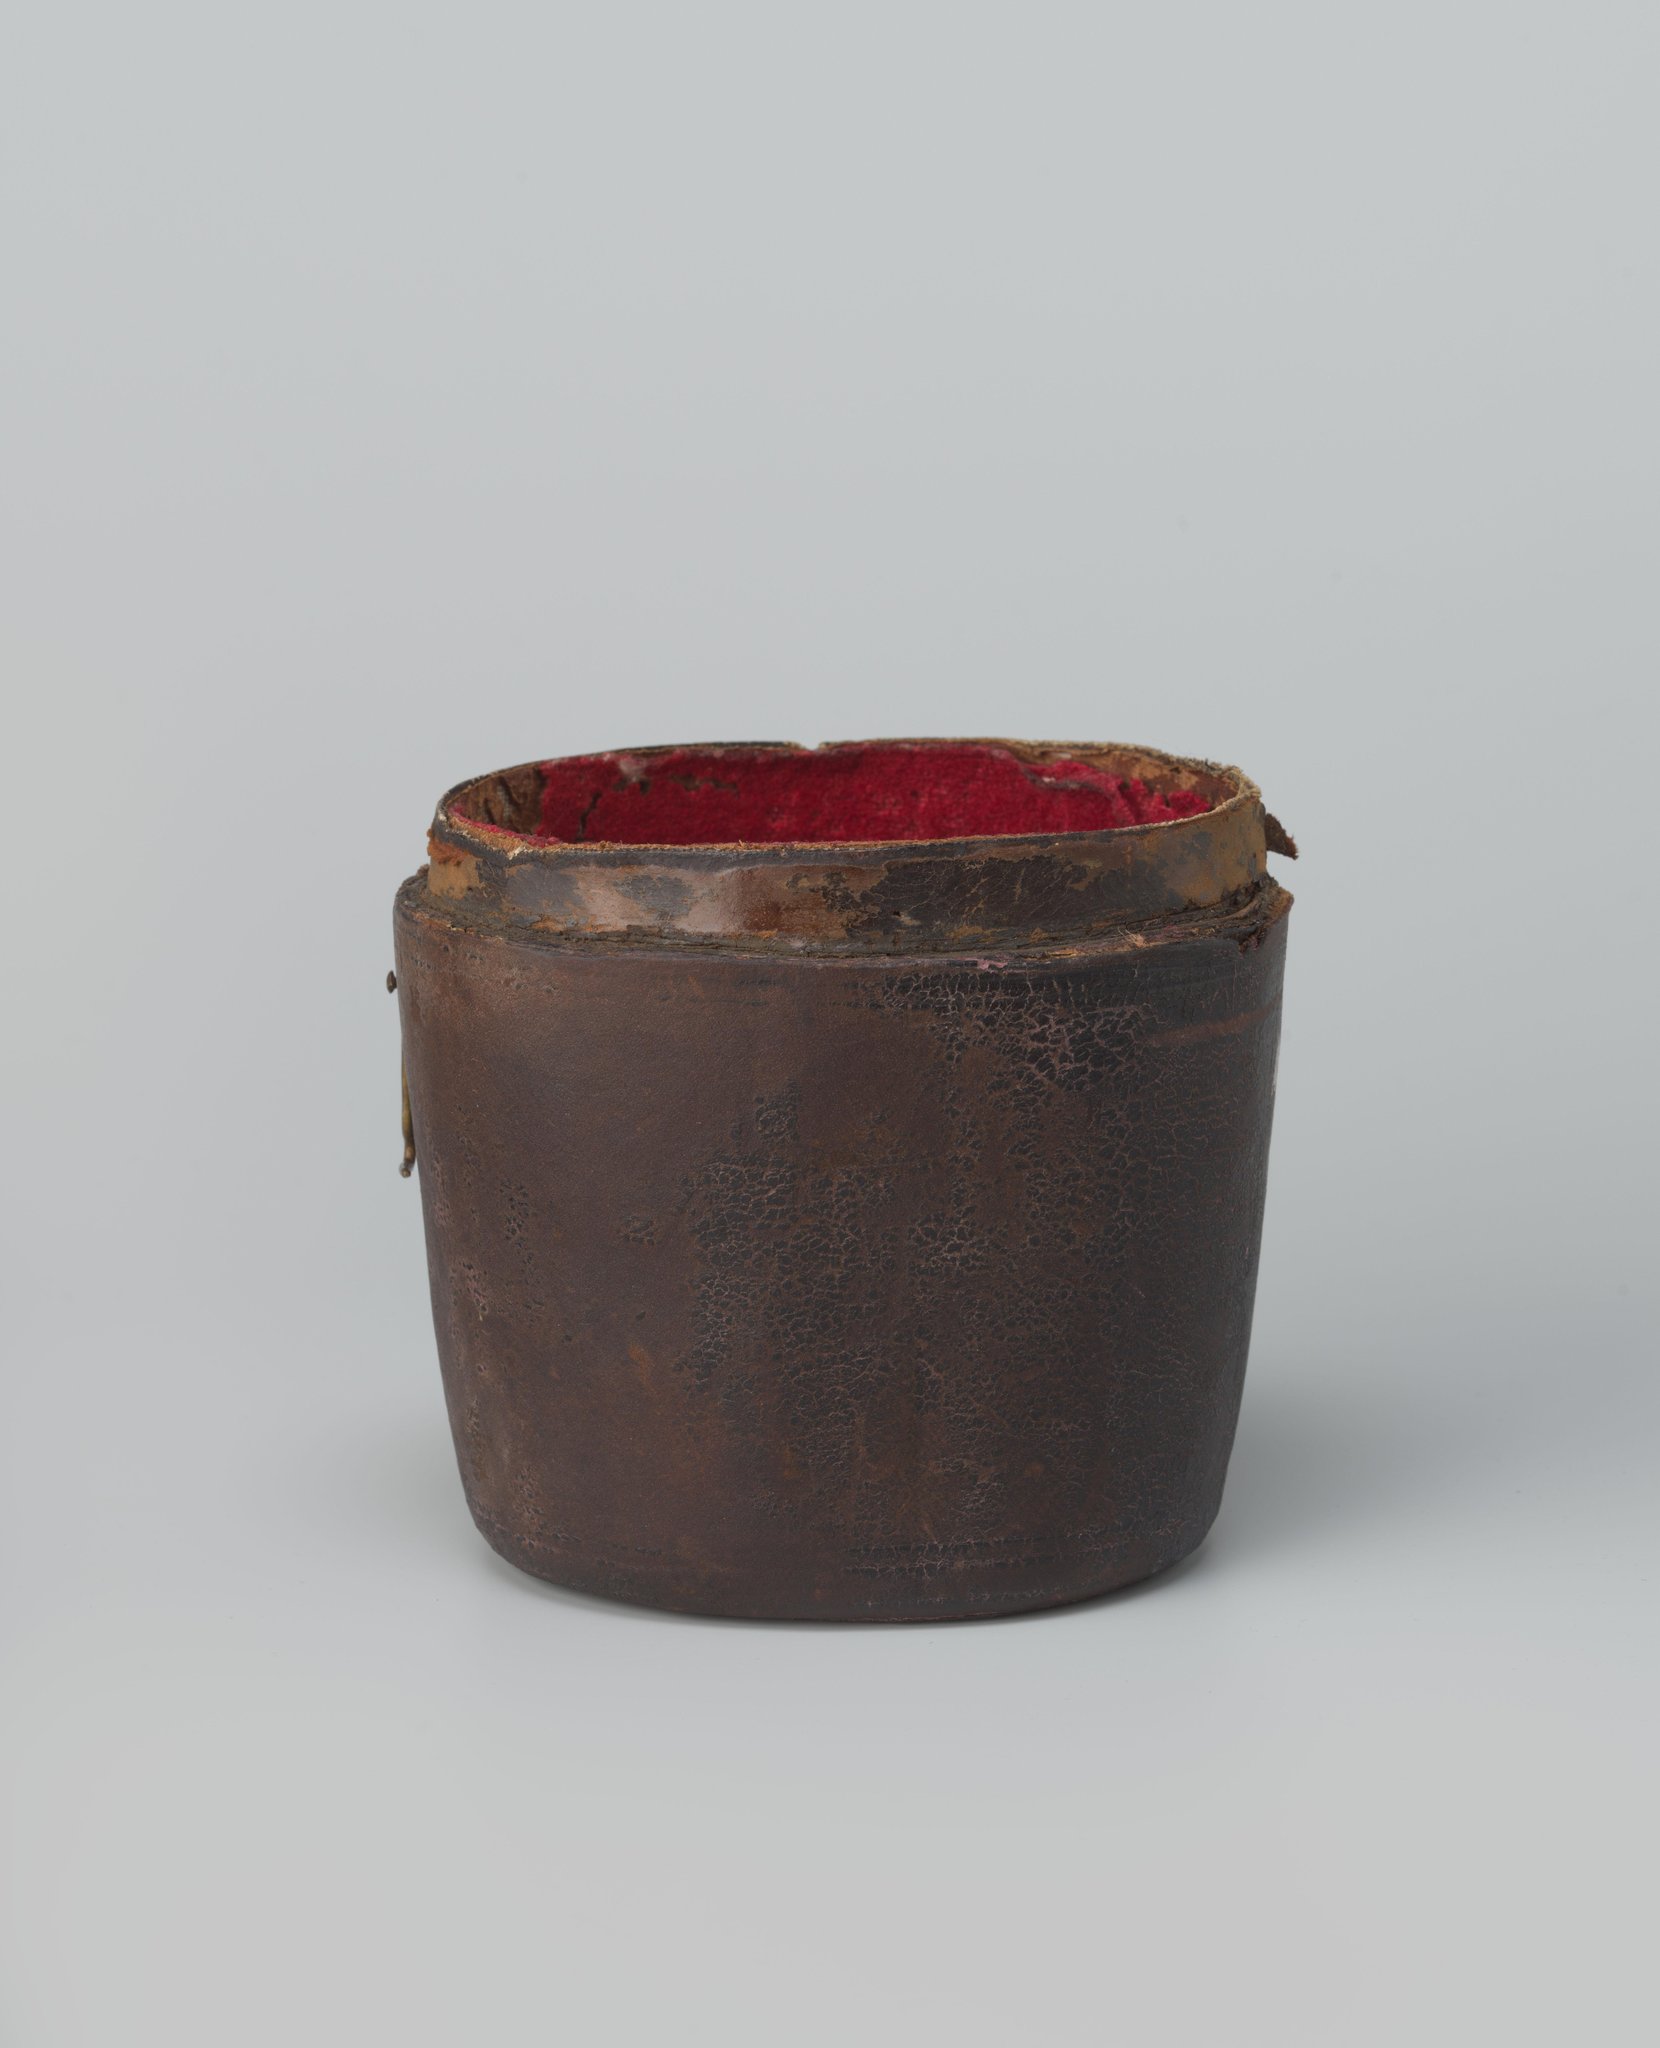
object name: case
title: Deel van leren foedraal voor goudrobijnglas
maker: Anonymous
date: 1600-1700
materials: leather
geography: europe